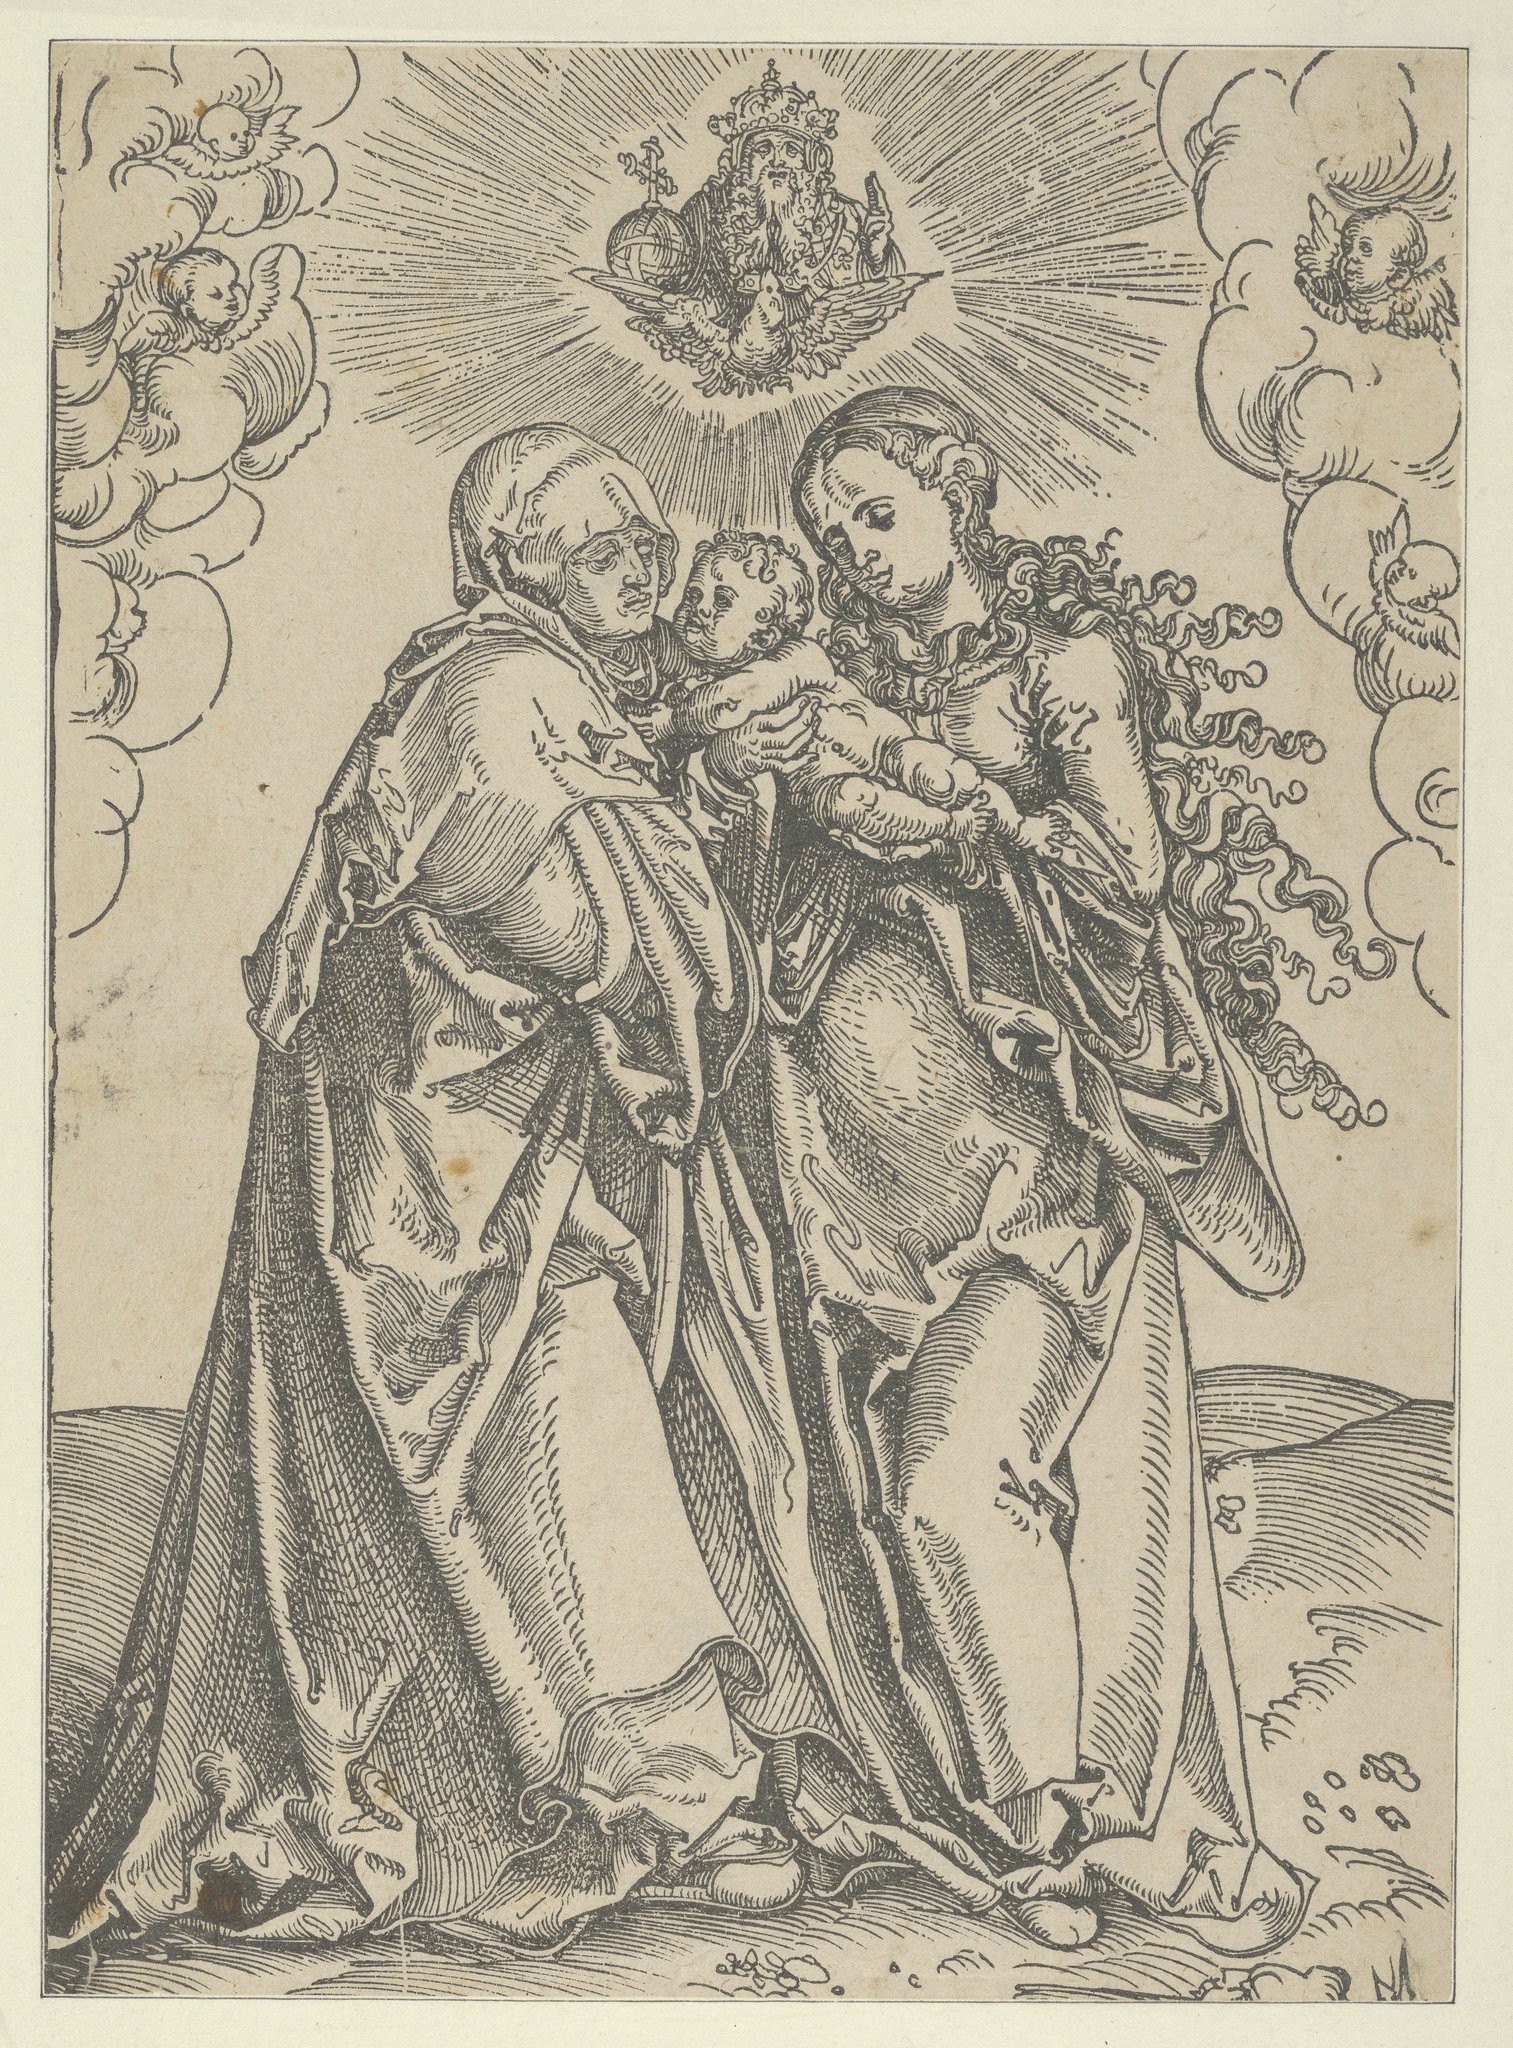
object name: print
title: St Anne and the Virgin with the Child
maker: lucas cranach the elder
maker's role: artist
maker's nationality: german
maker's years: 1472-1553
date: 1472-1553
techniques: woodcut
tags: angels,madonna and child,saint anne